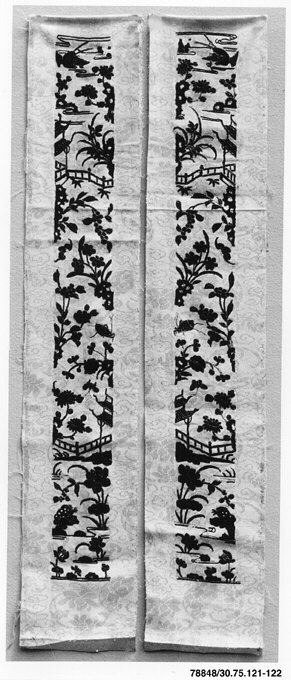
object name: sleeve band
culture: chinese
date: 1801-1900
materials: metal thread, silk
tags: flowers